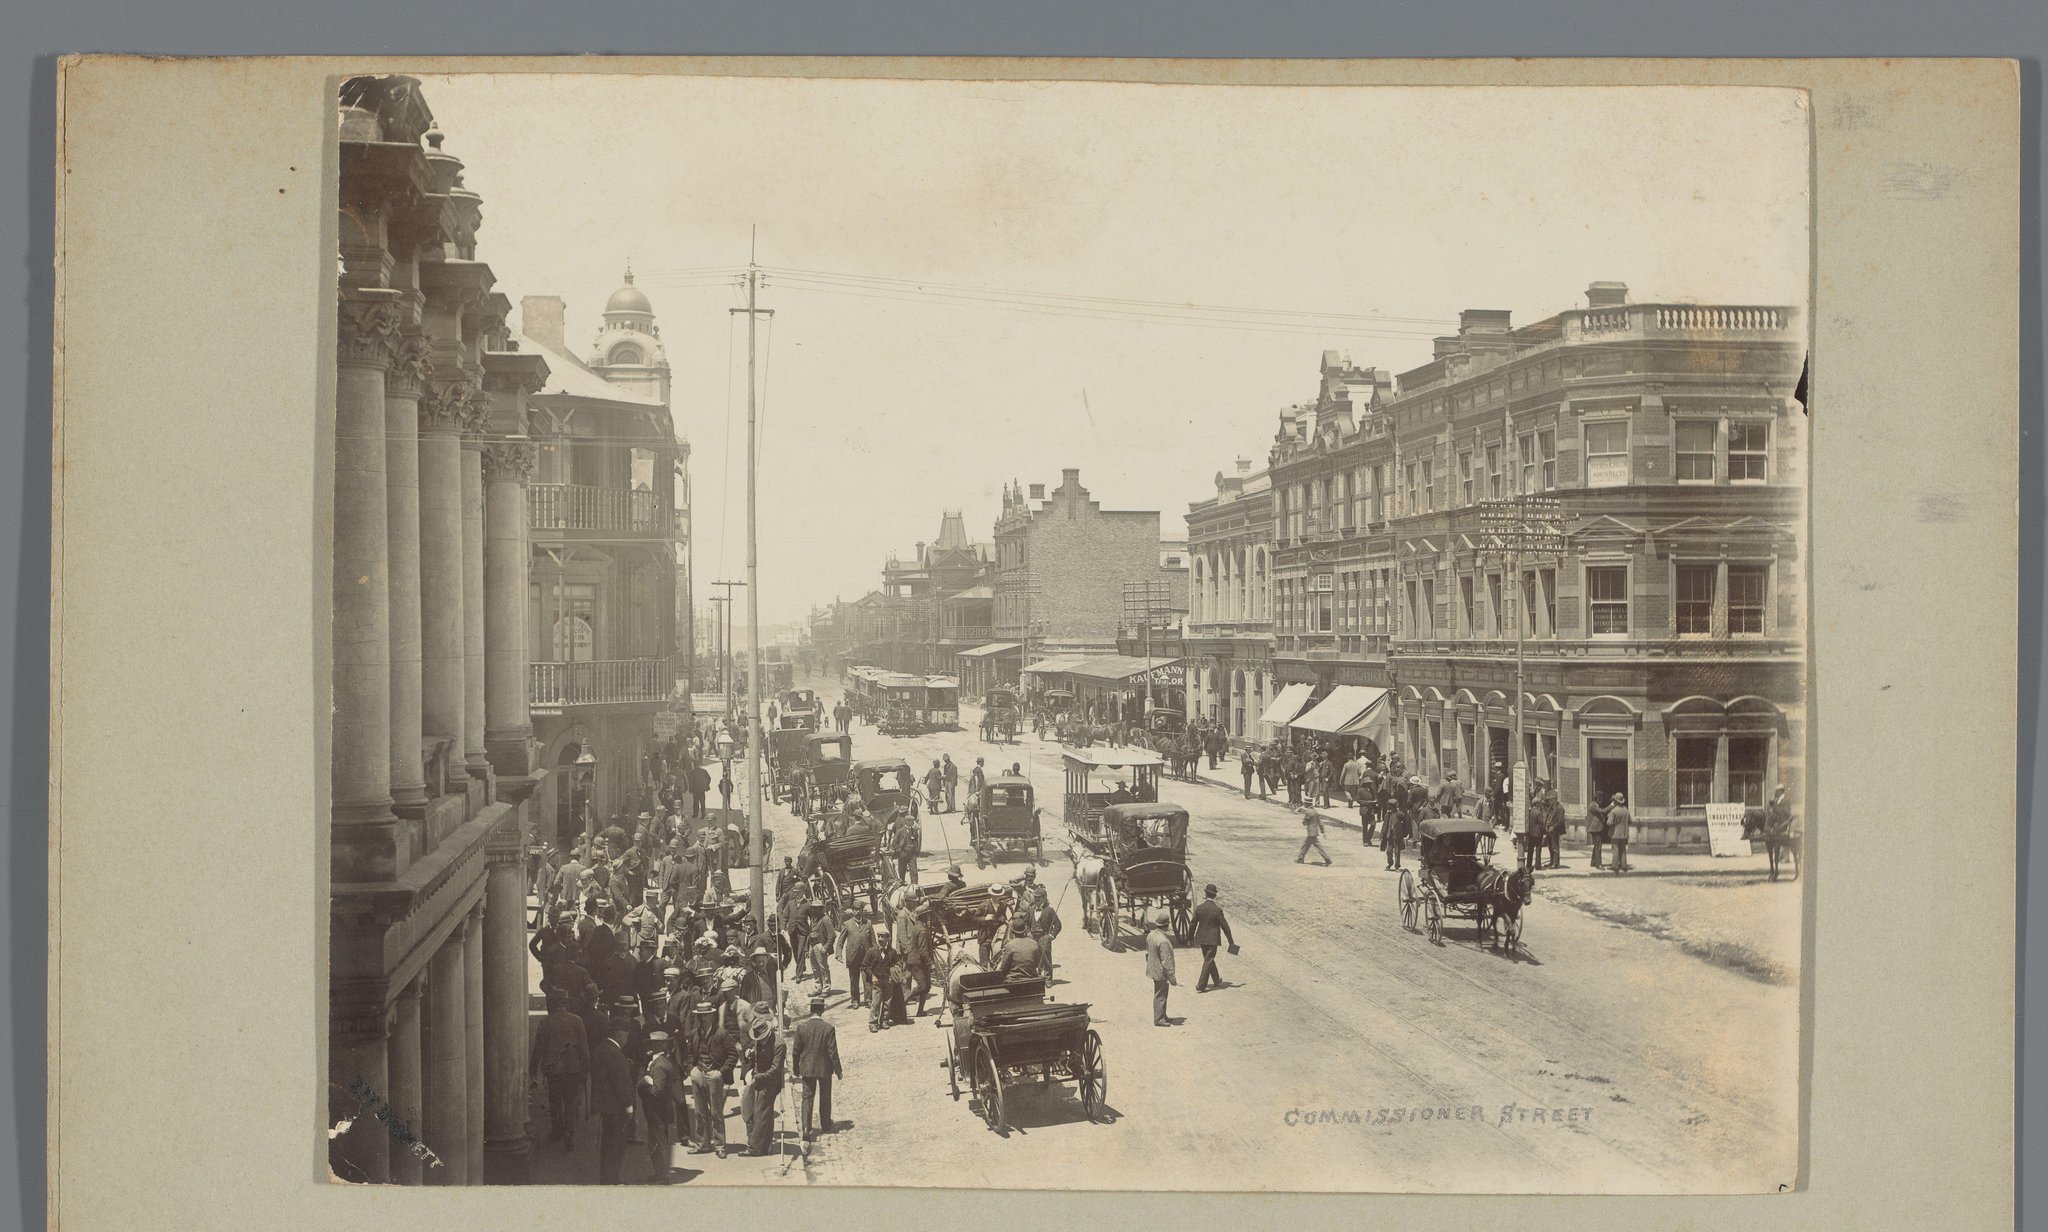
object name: photograph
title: Commissioner Street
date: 1890-1905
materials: paper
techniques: gelatin silver print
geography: johannesburg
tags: four-wheeled, animal-drawn vehicle, e.g.: cab, carriage, coach, street, johannesburg